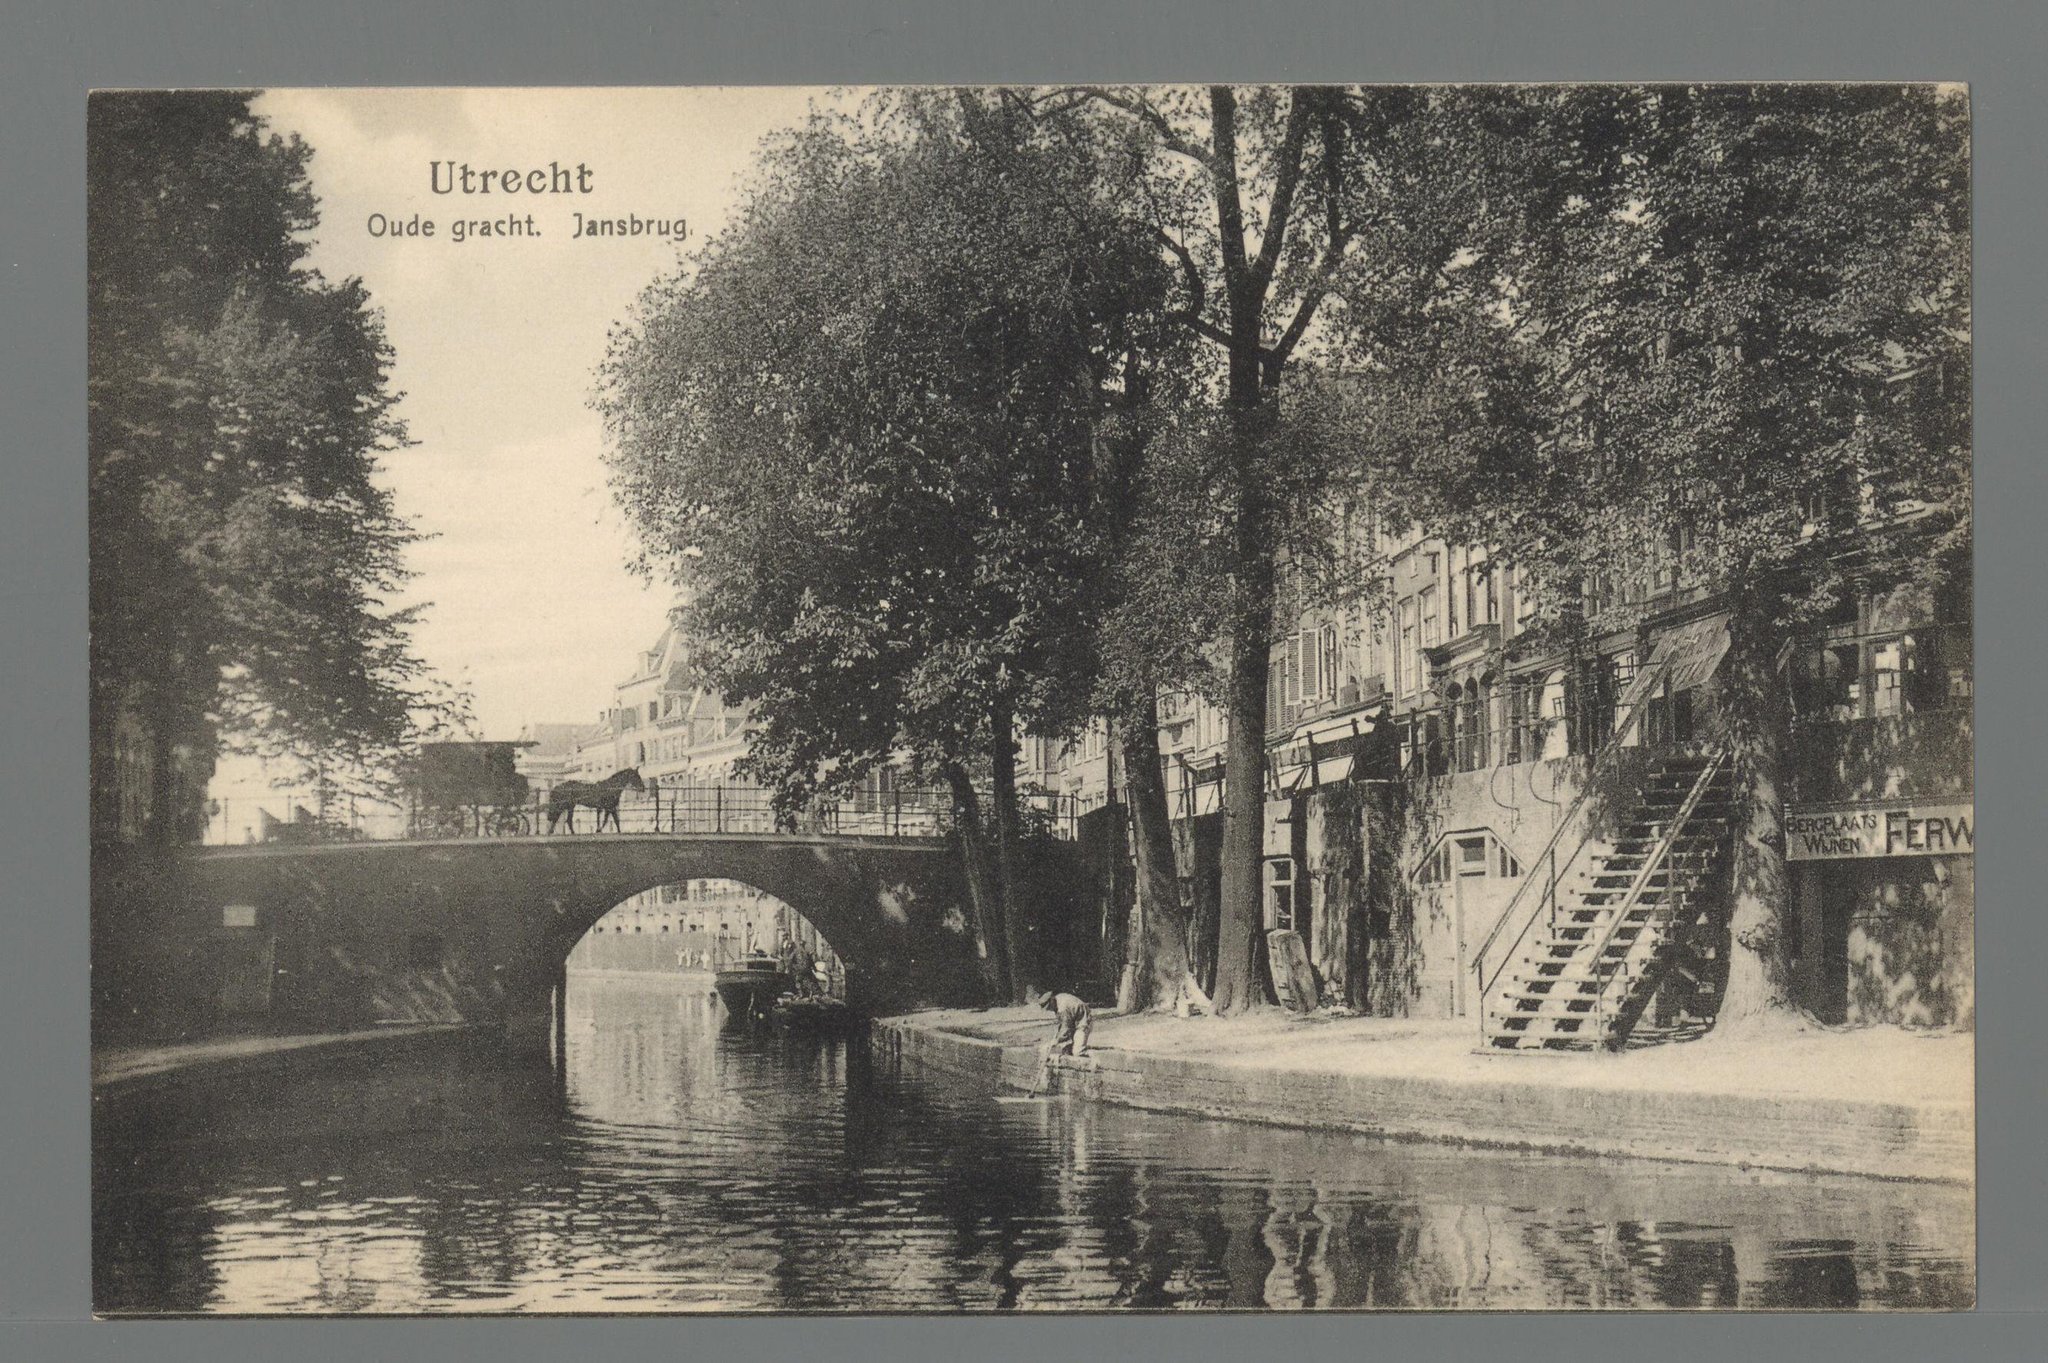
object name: ansichtkaart, prentbriefkaart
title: Utrecht. Oude gracht. Jansbrug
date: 1892-1905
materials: cardboard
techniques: photograph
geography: utrecht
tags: canals, waters (in city), bridge in city across river, canal, etc., street